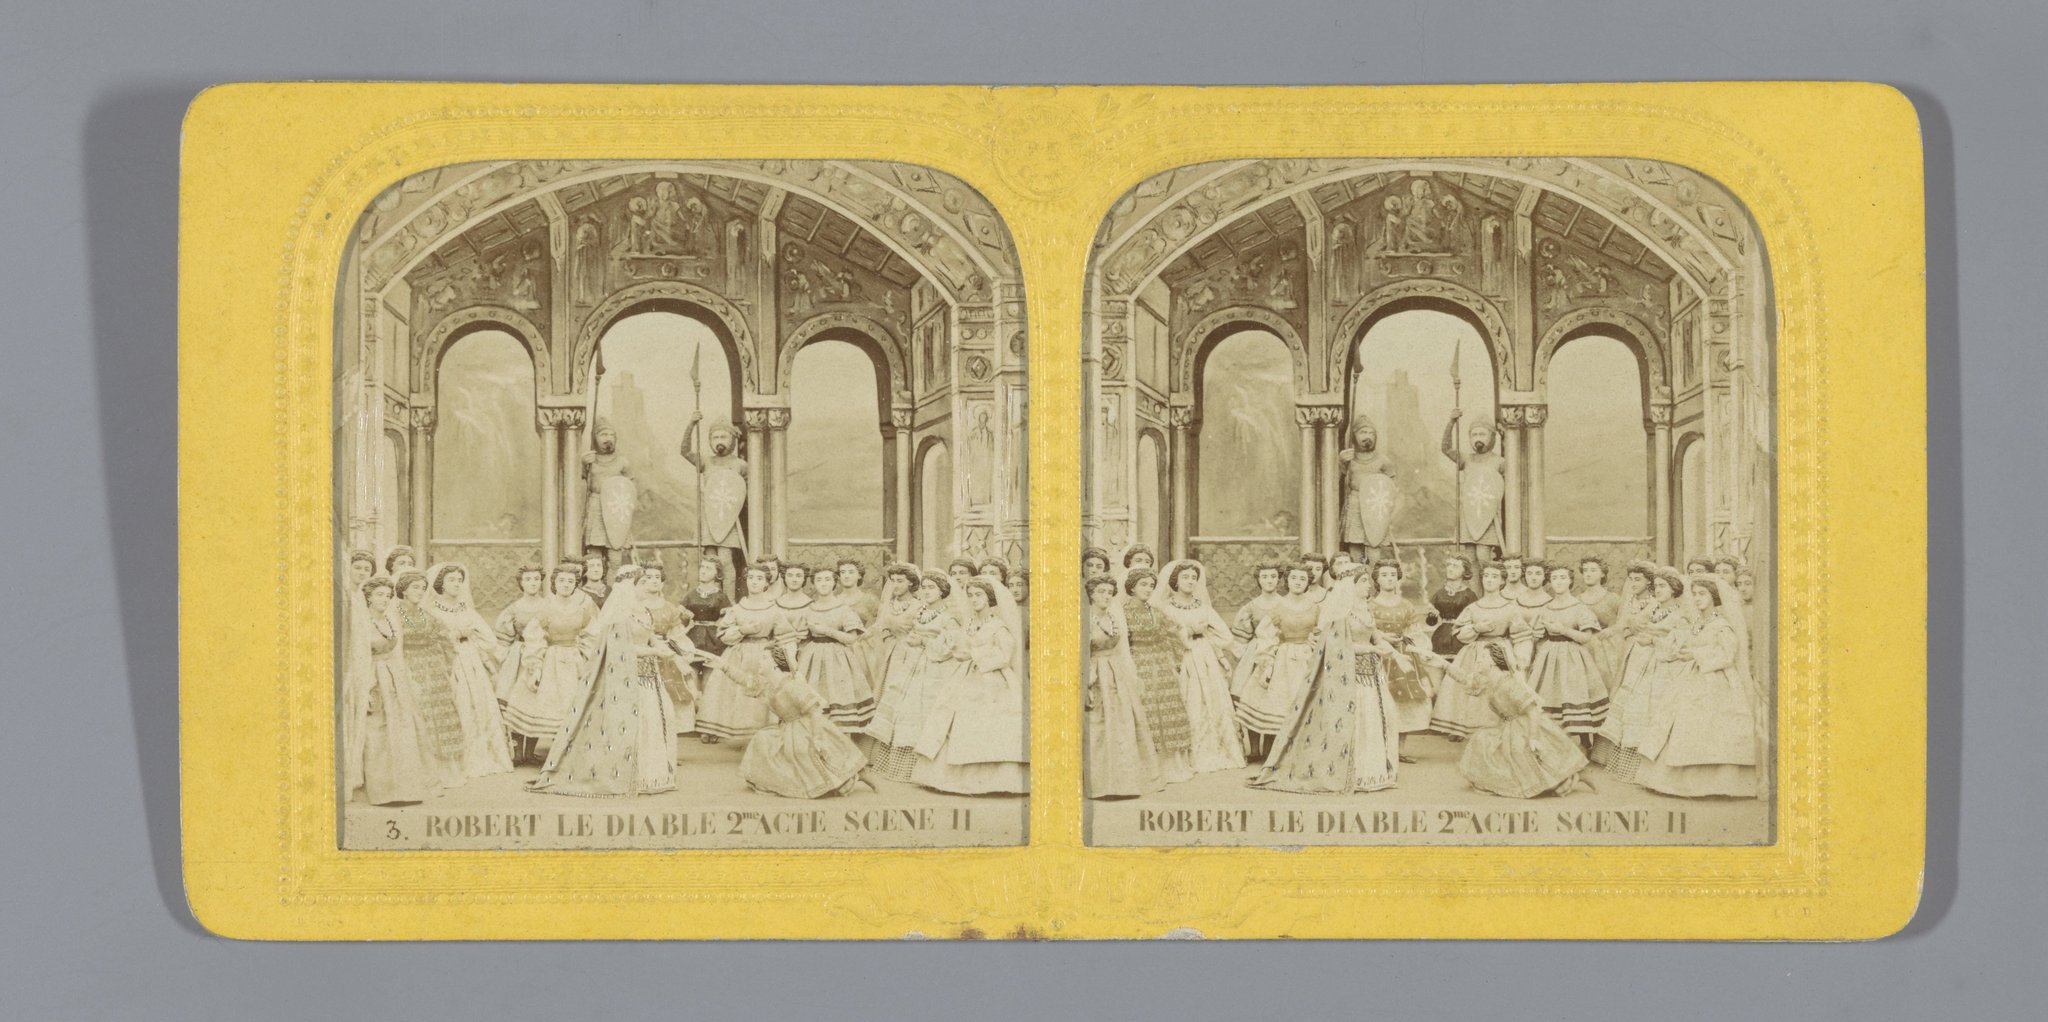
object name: tissue stereograph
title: Tweede bedrijf, tweede scène van Robert le Diable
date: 1873-1874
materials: cardboard, paper, photographic support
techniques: albumen print, cutting, hand coloring, perforating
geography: paris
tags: opera, paris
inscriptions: inscription: ‘Toutes les épreuves non revêtues du timbre ci-contre/ seront considérées comme contrefacon, le Dépôt/ ayant été fait en France selon la loi et à l' Etranger/ conformément aux conventions internationales./ PROPRIÉTÉ/ B.K./ PARIS’, inscription: ‘DÉPOSÉ/ Ch D’, number: ‘3.’